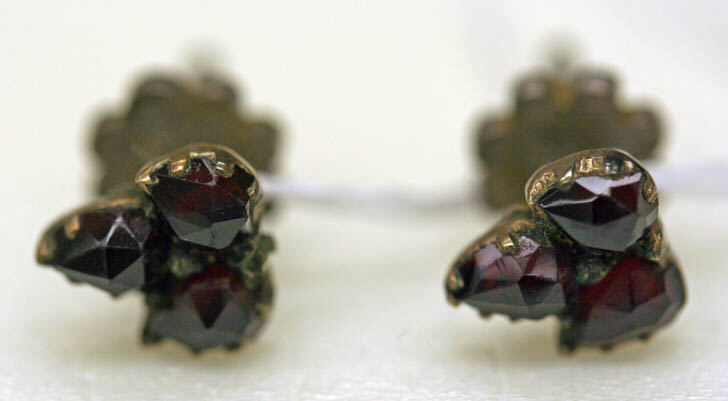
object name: pierced earring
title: Pierced earrings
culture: american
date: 1885